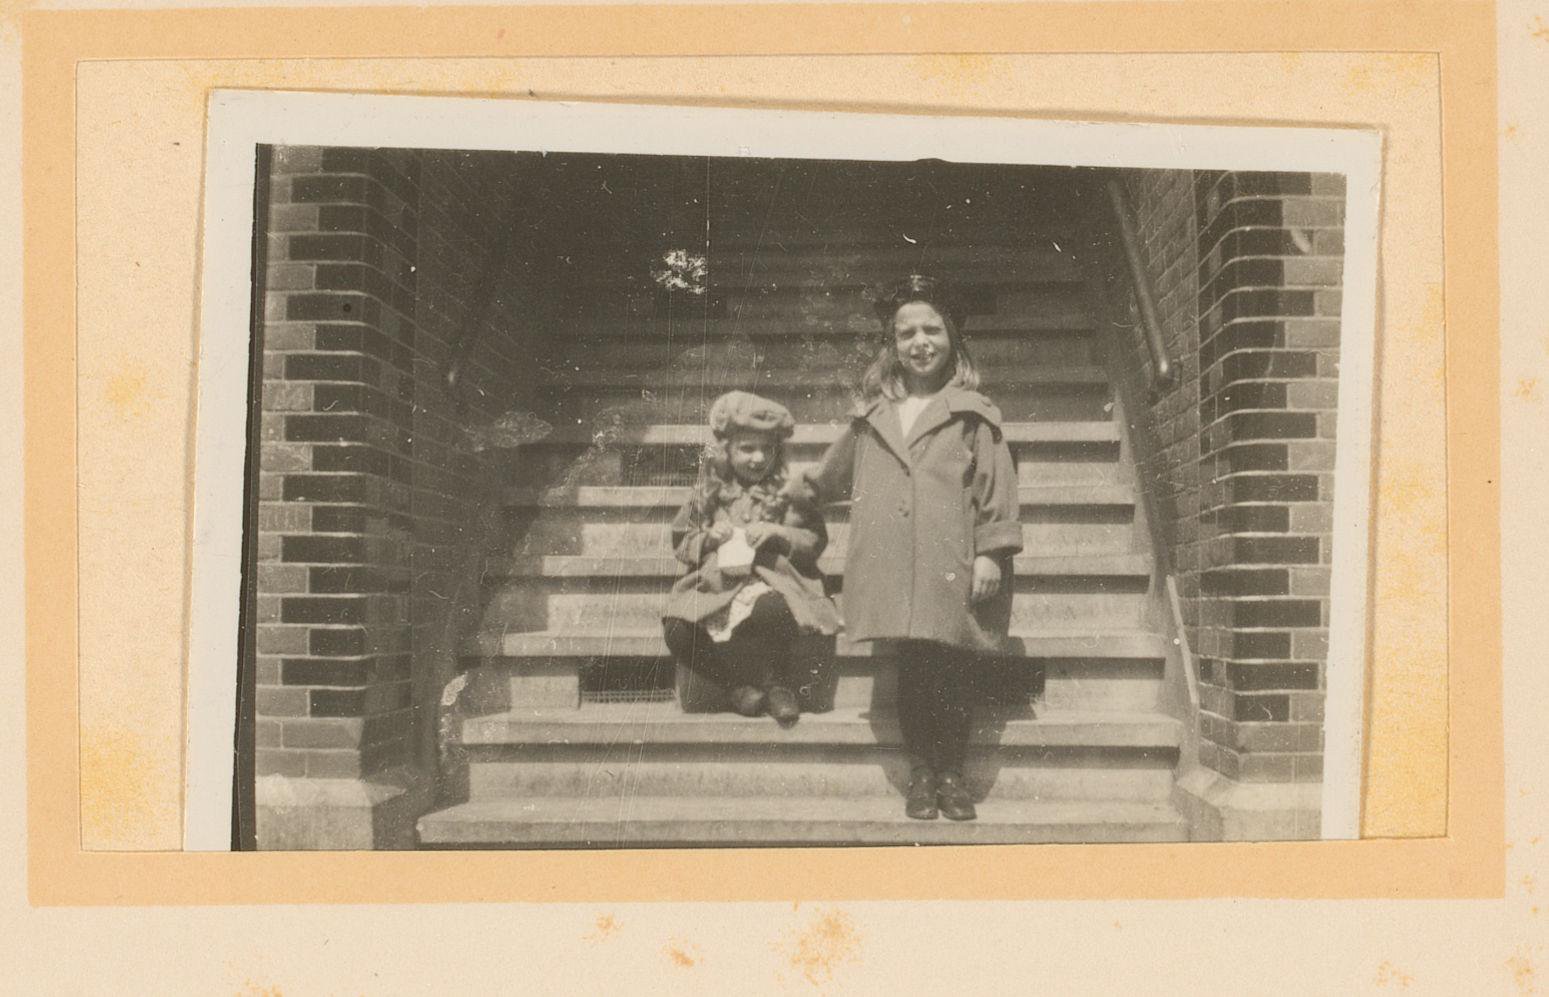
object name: photograph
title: Twee meisjes op een stenen buitentrap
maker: Anonymous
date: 1927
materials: paper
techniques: gelatin silver print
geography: netherlands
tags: girl (child between toddler and youth), netherlands